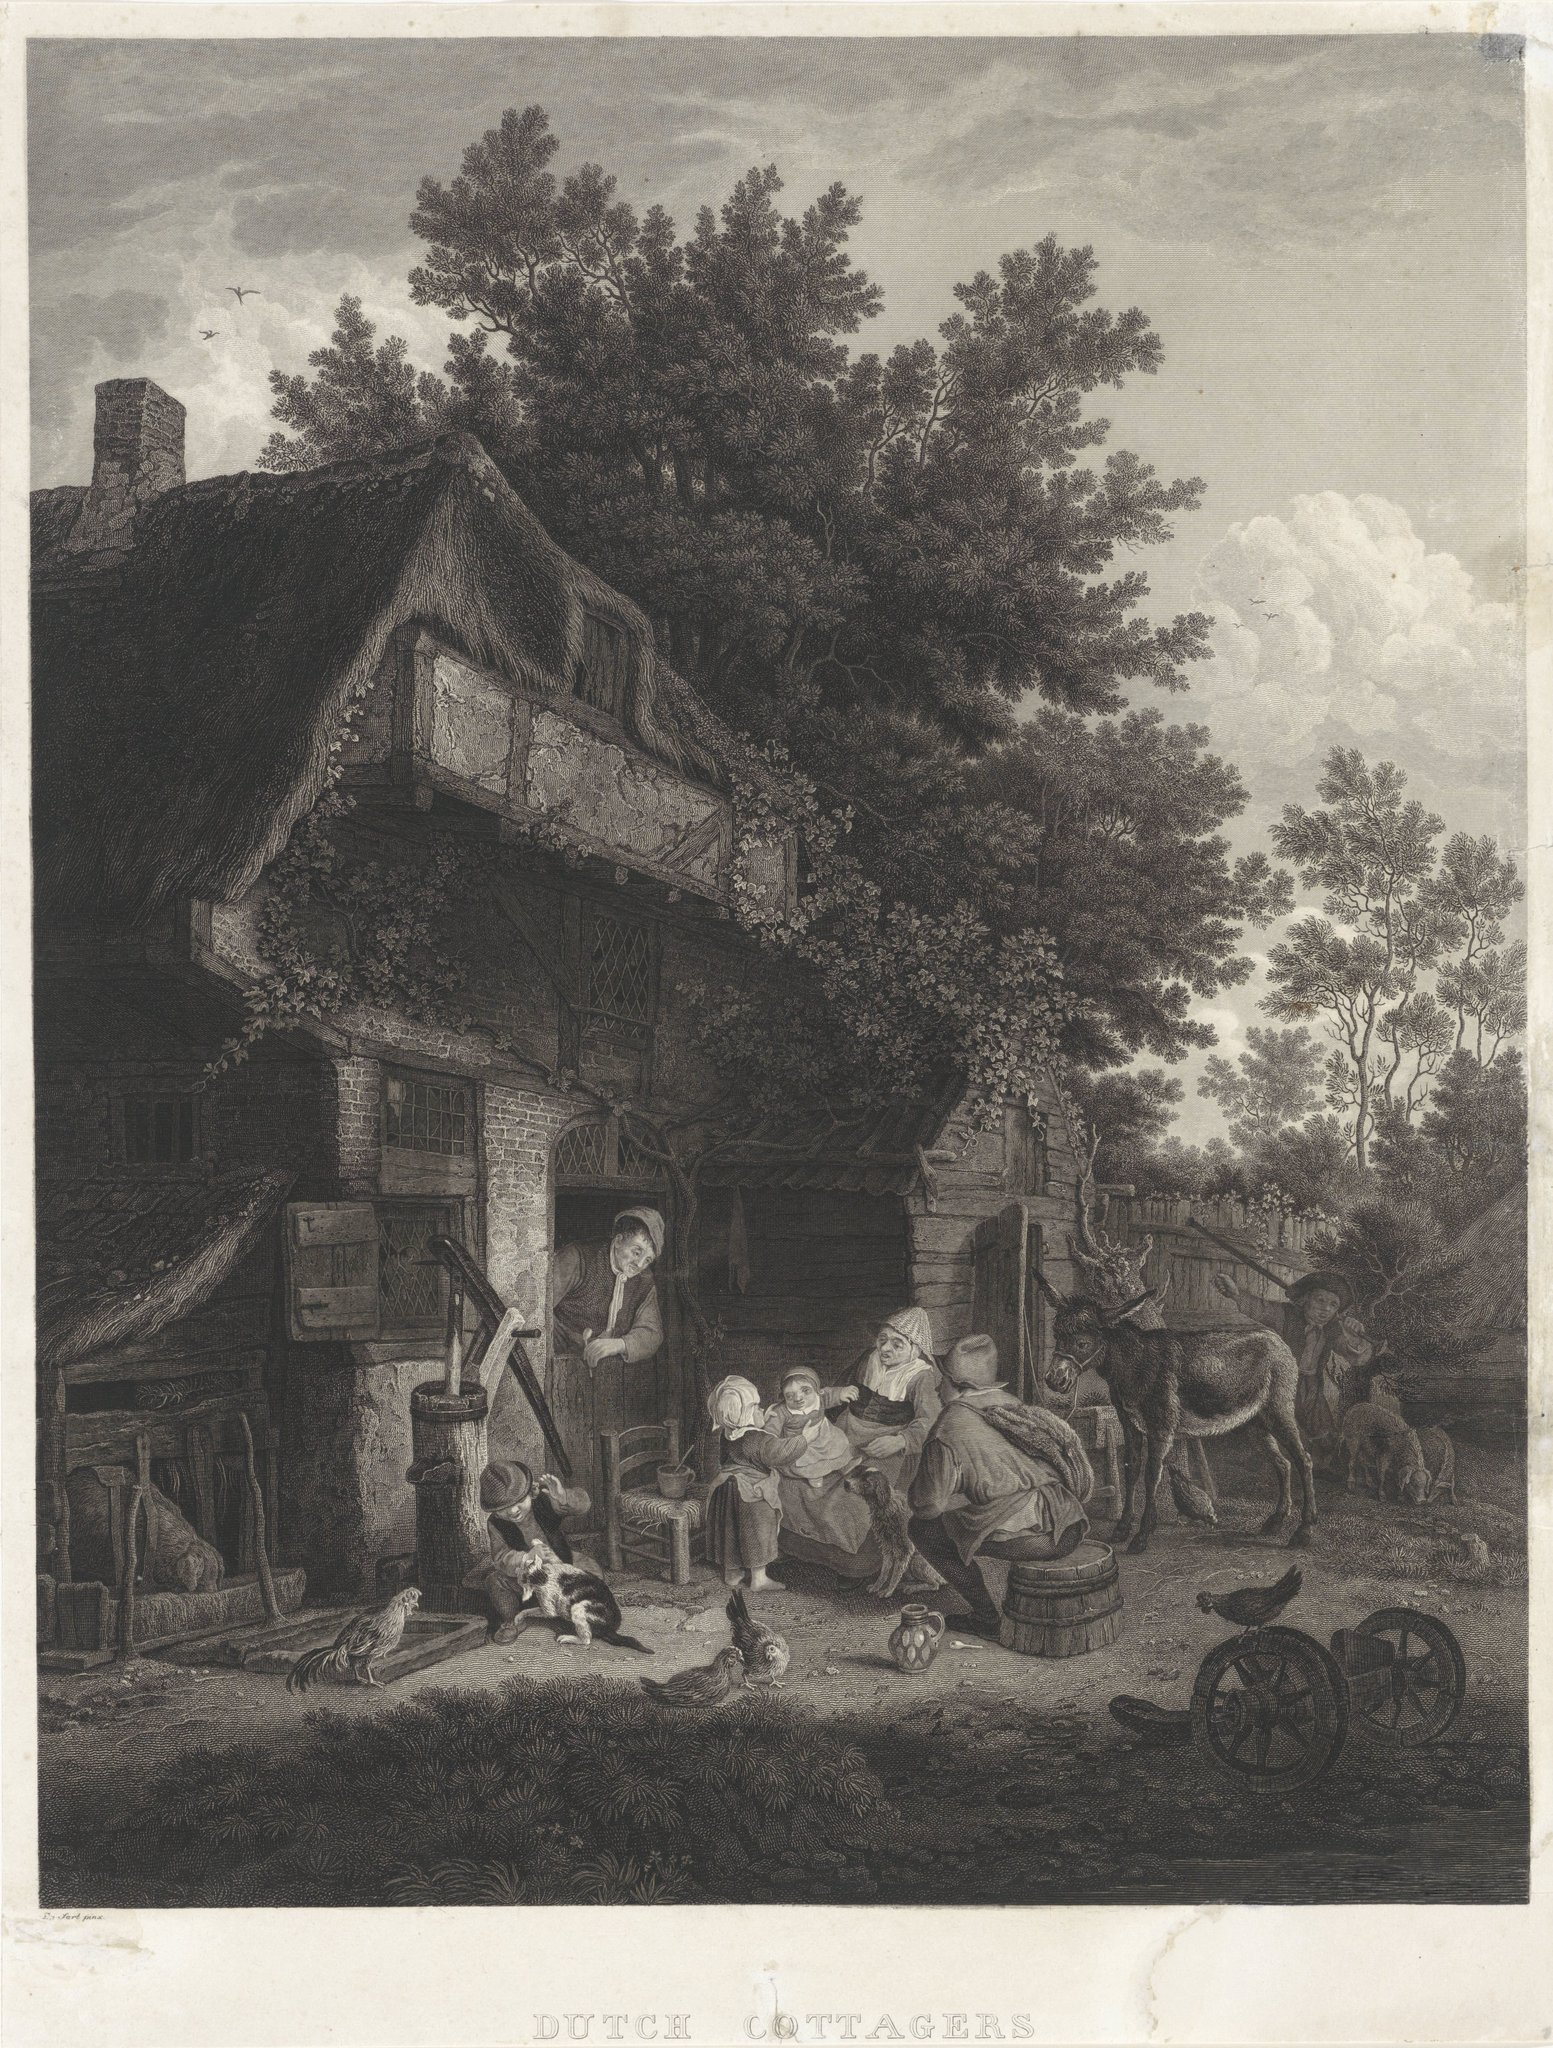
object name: print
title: Boerengezin op hun erf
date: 1822-1882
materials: paper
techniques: engraving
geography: haarlem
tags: animals, family group, especially parents with their child(ren), farm (building)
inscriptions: collector's mark: Lugt 2228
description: De prent is zeer waarschijnlijk vervaardigd door Johann Gabriel Friedrich Poppel, die ook enige tijd in Londen werkzaam was, wat ook een verklaring zou kunnen zijn voor de Engelstalige titel.